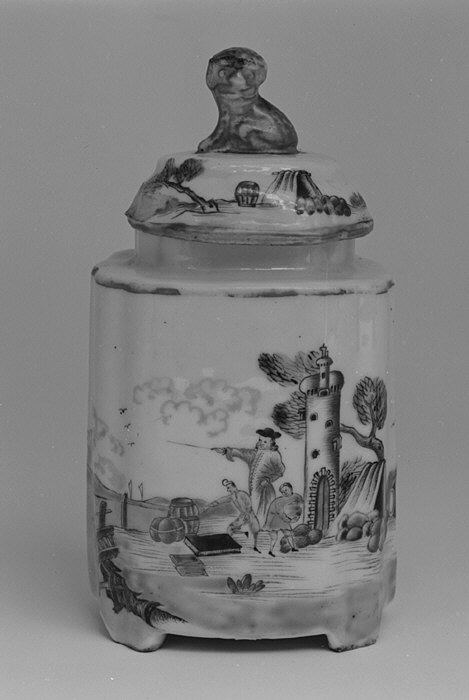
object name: tea caddy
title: Tea caddy (part of a service)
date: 1750-1770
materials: hard paste porcelain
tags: men